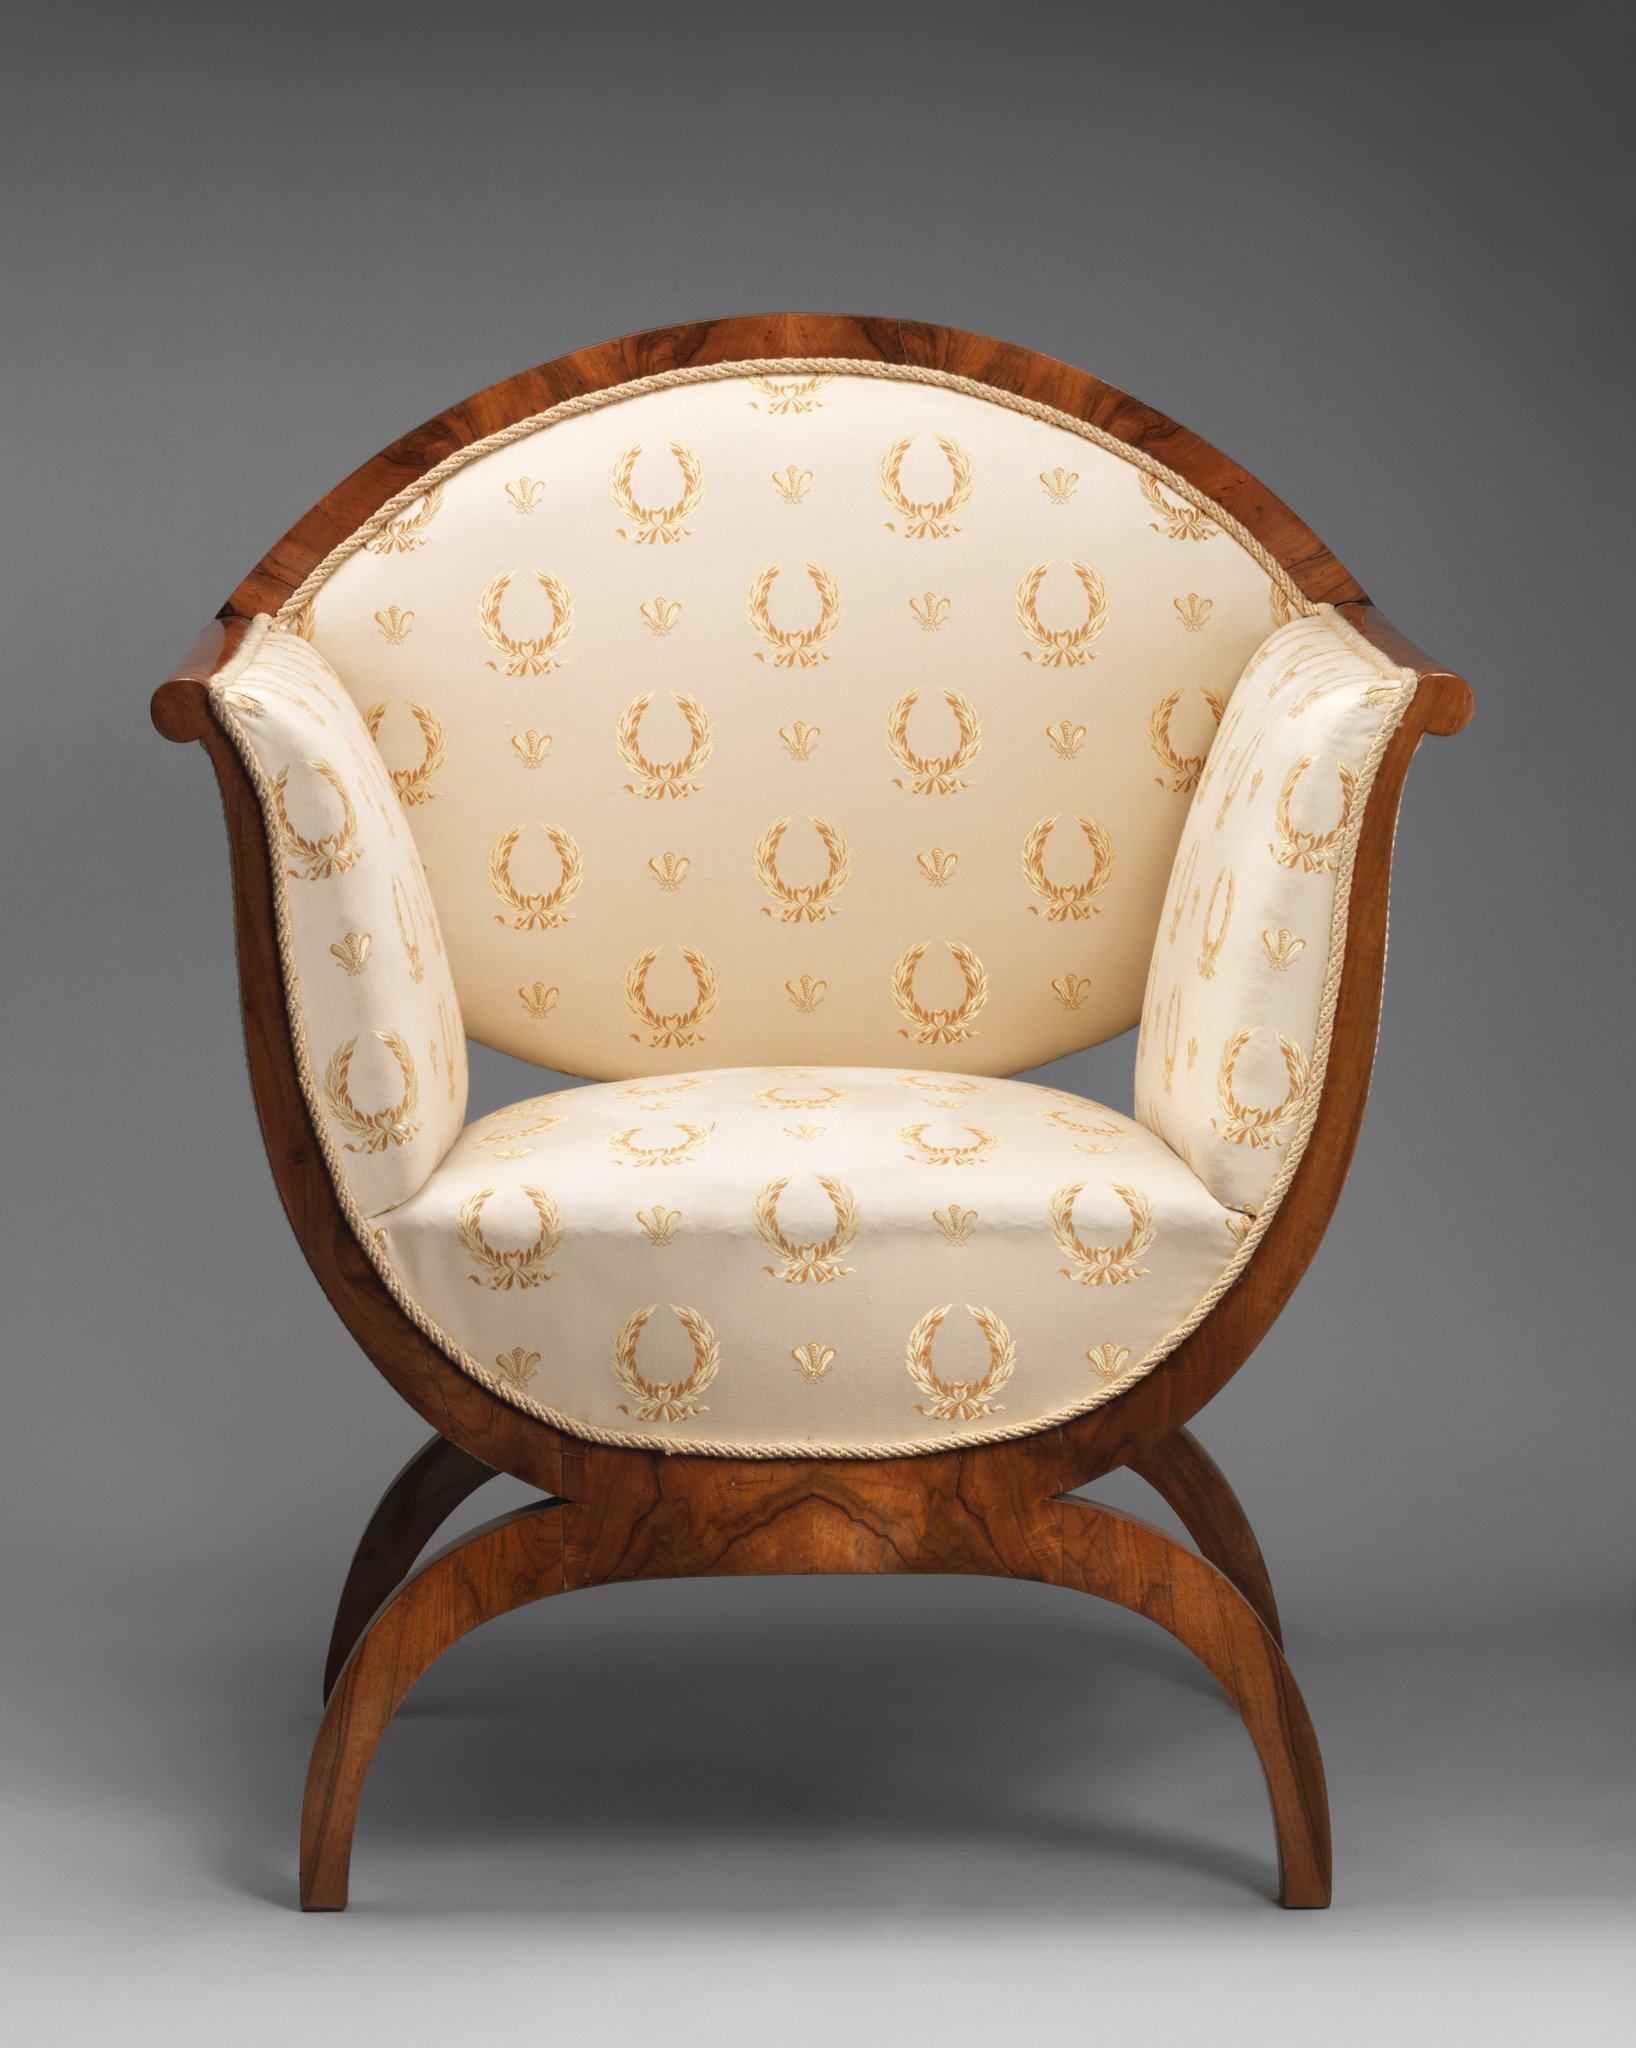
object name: armchair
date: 1830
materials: wood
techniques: veneering